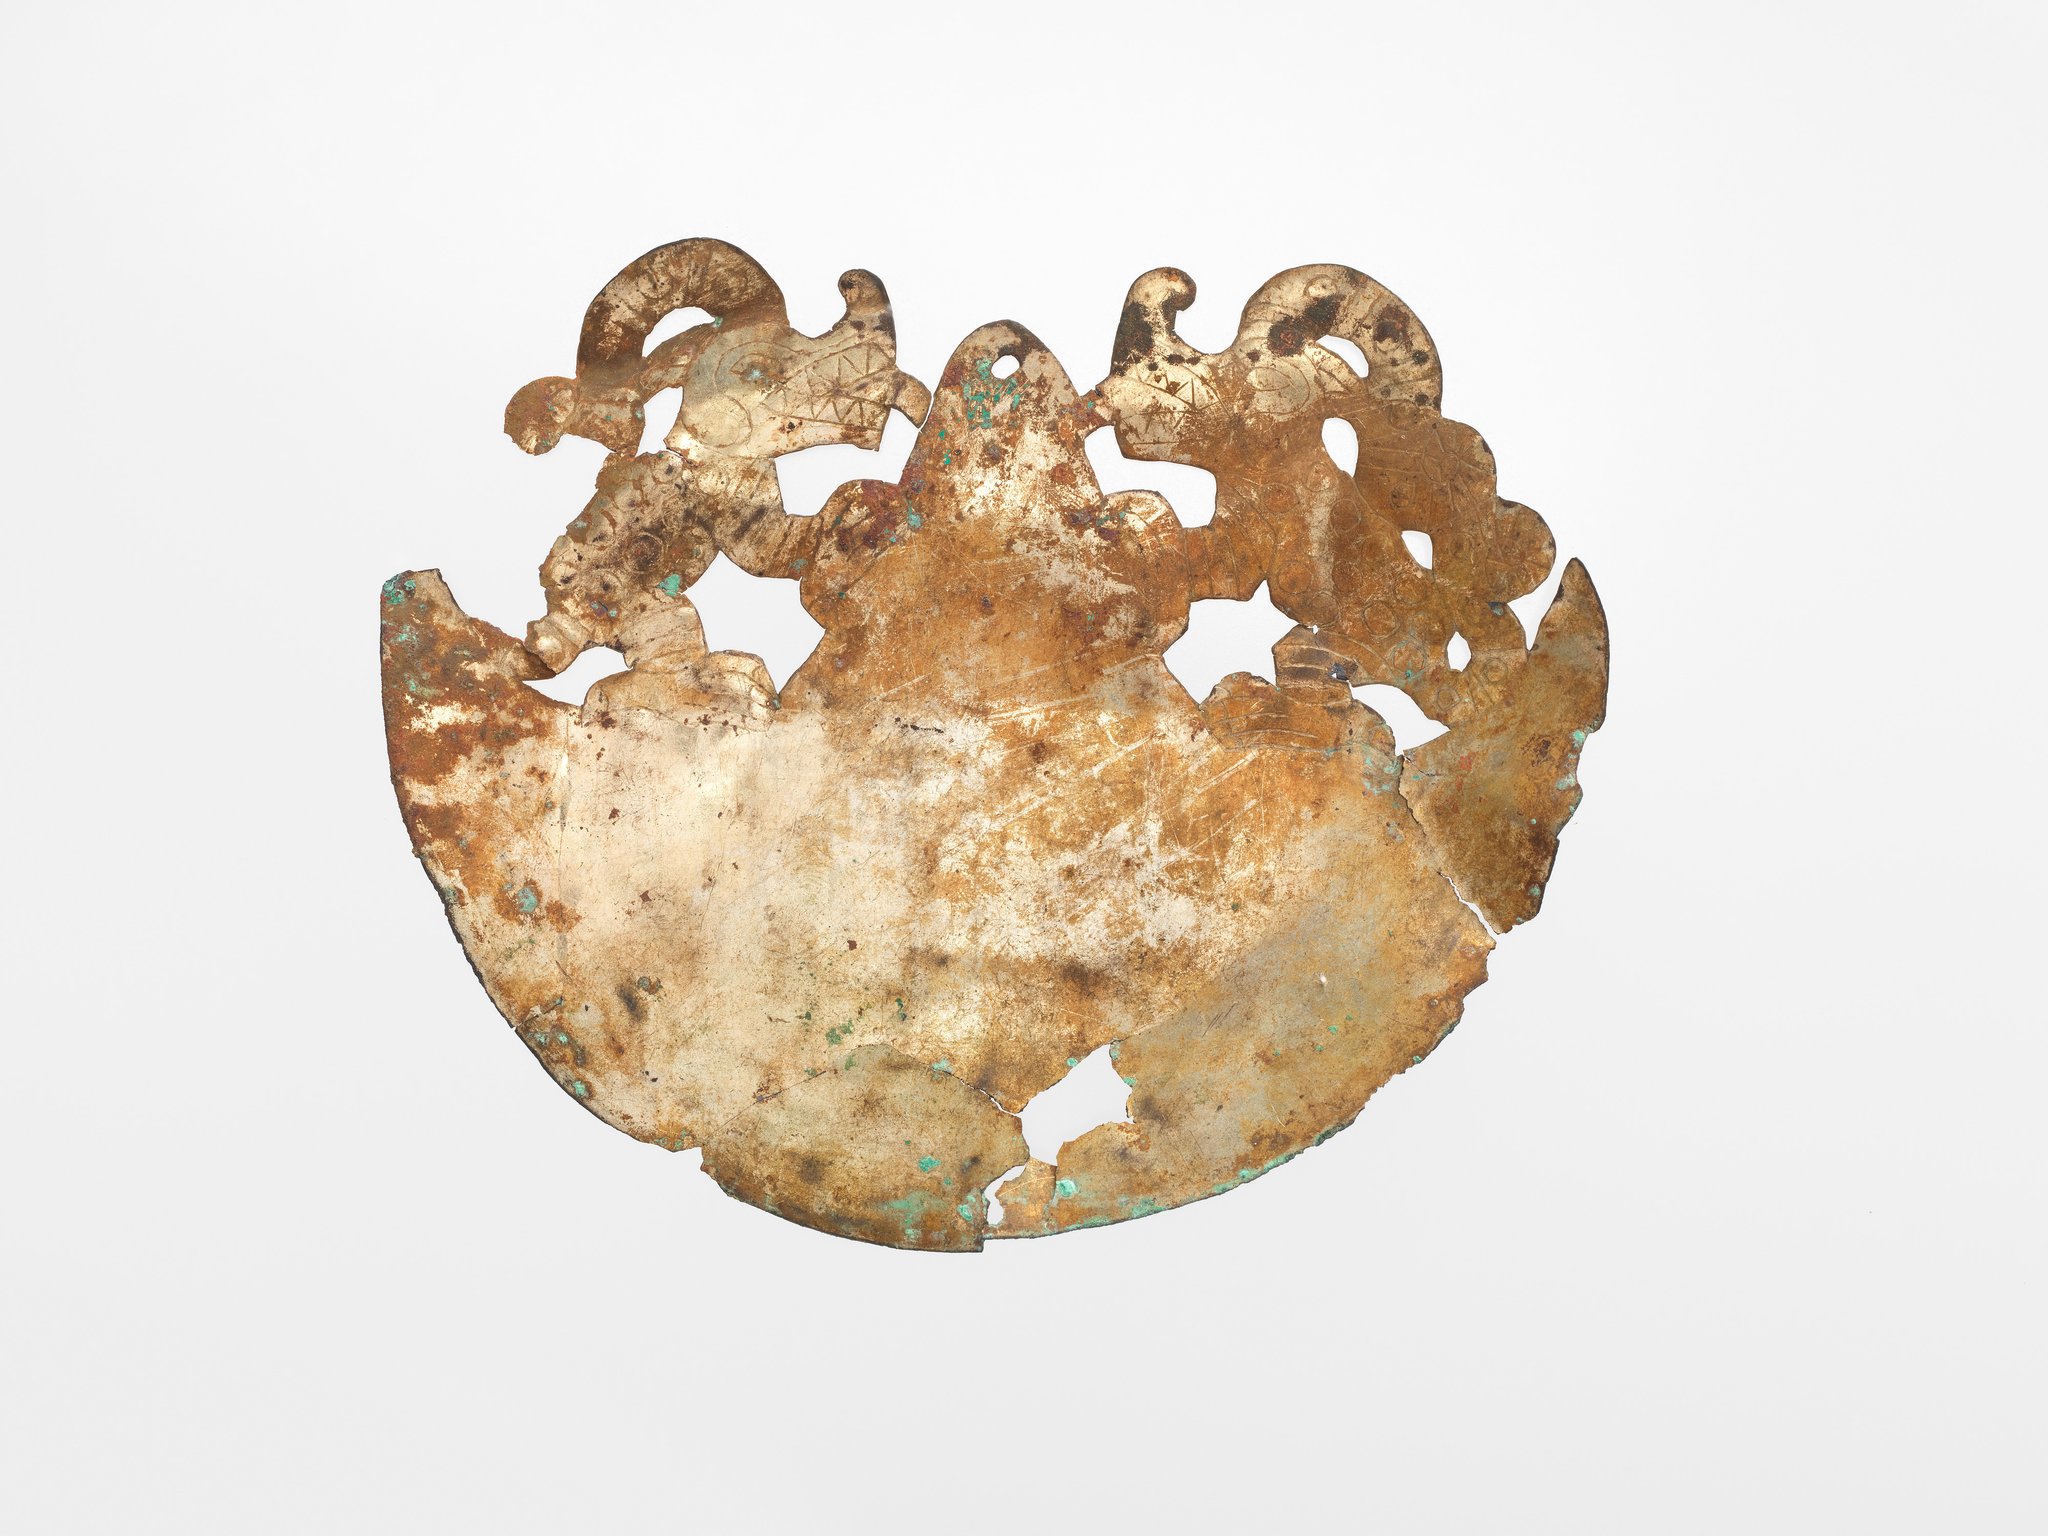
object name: ornament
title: Animal Ornament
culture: moche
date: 501-700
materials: gilt copper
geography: peru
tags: animals